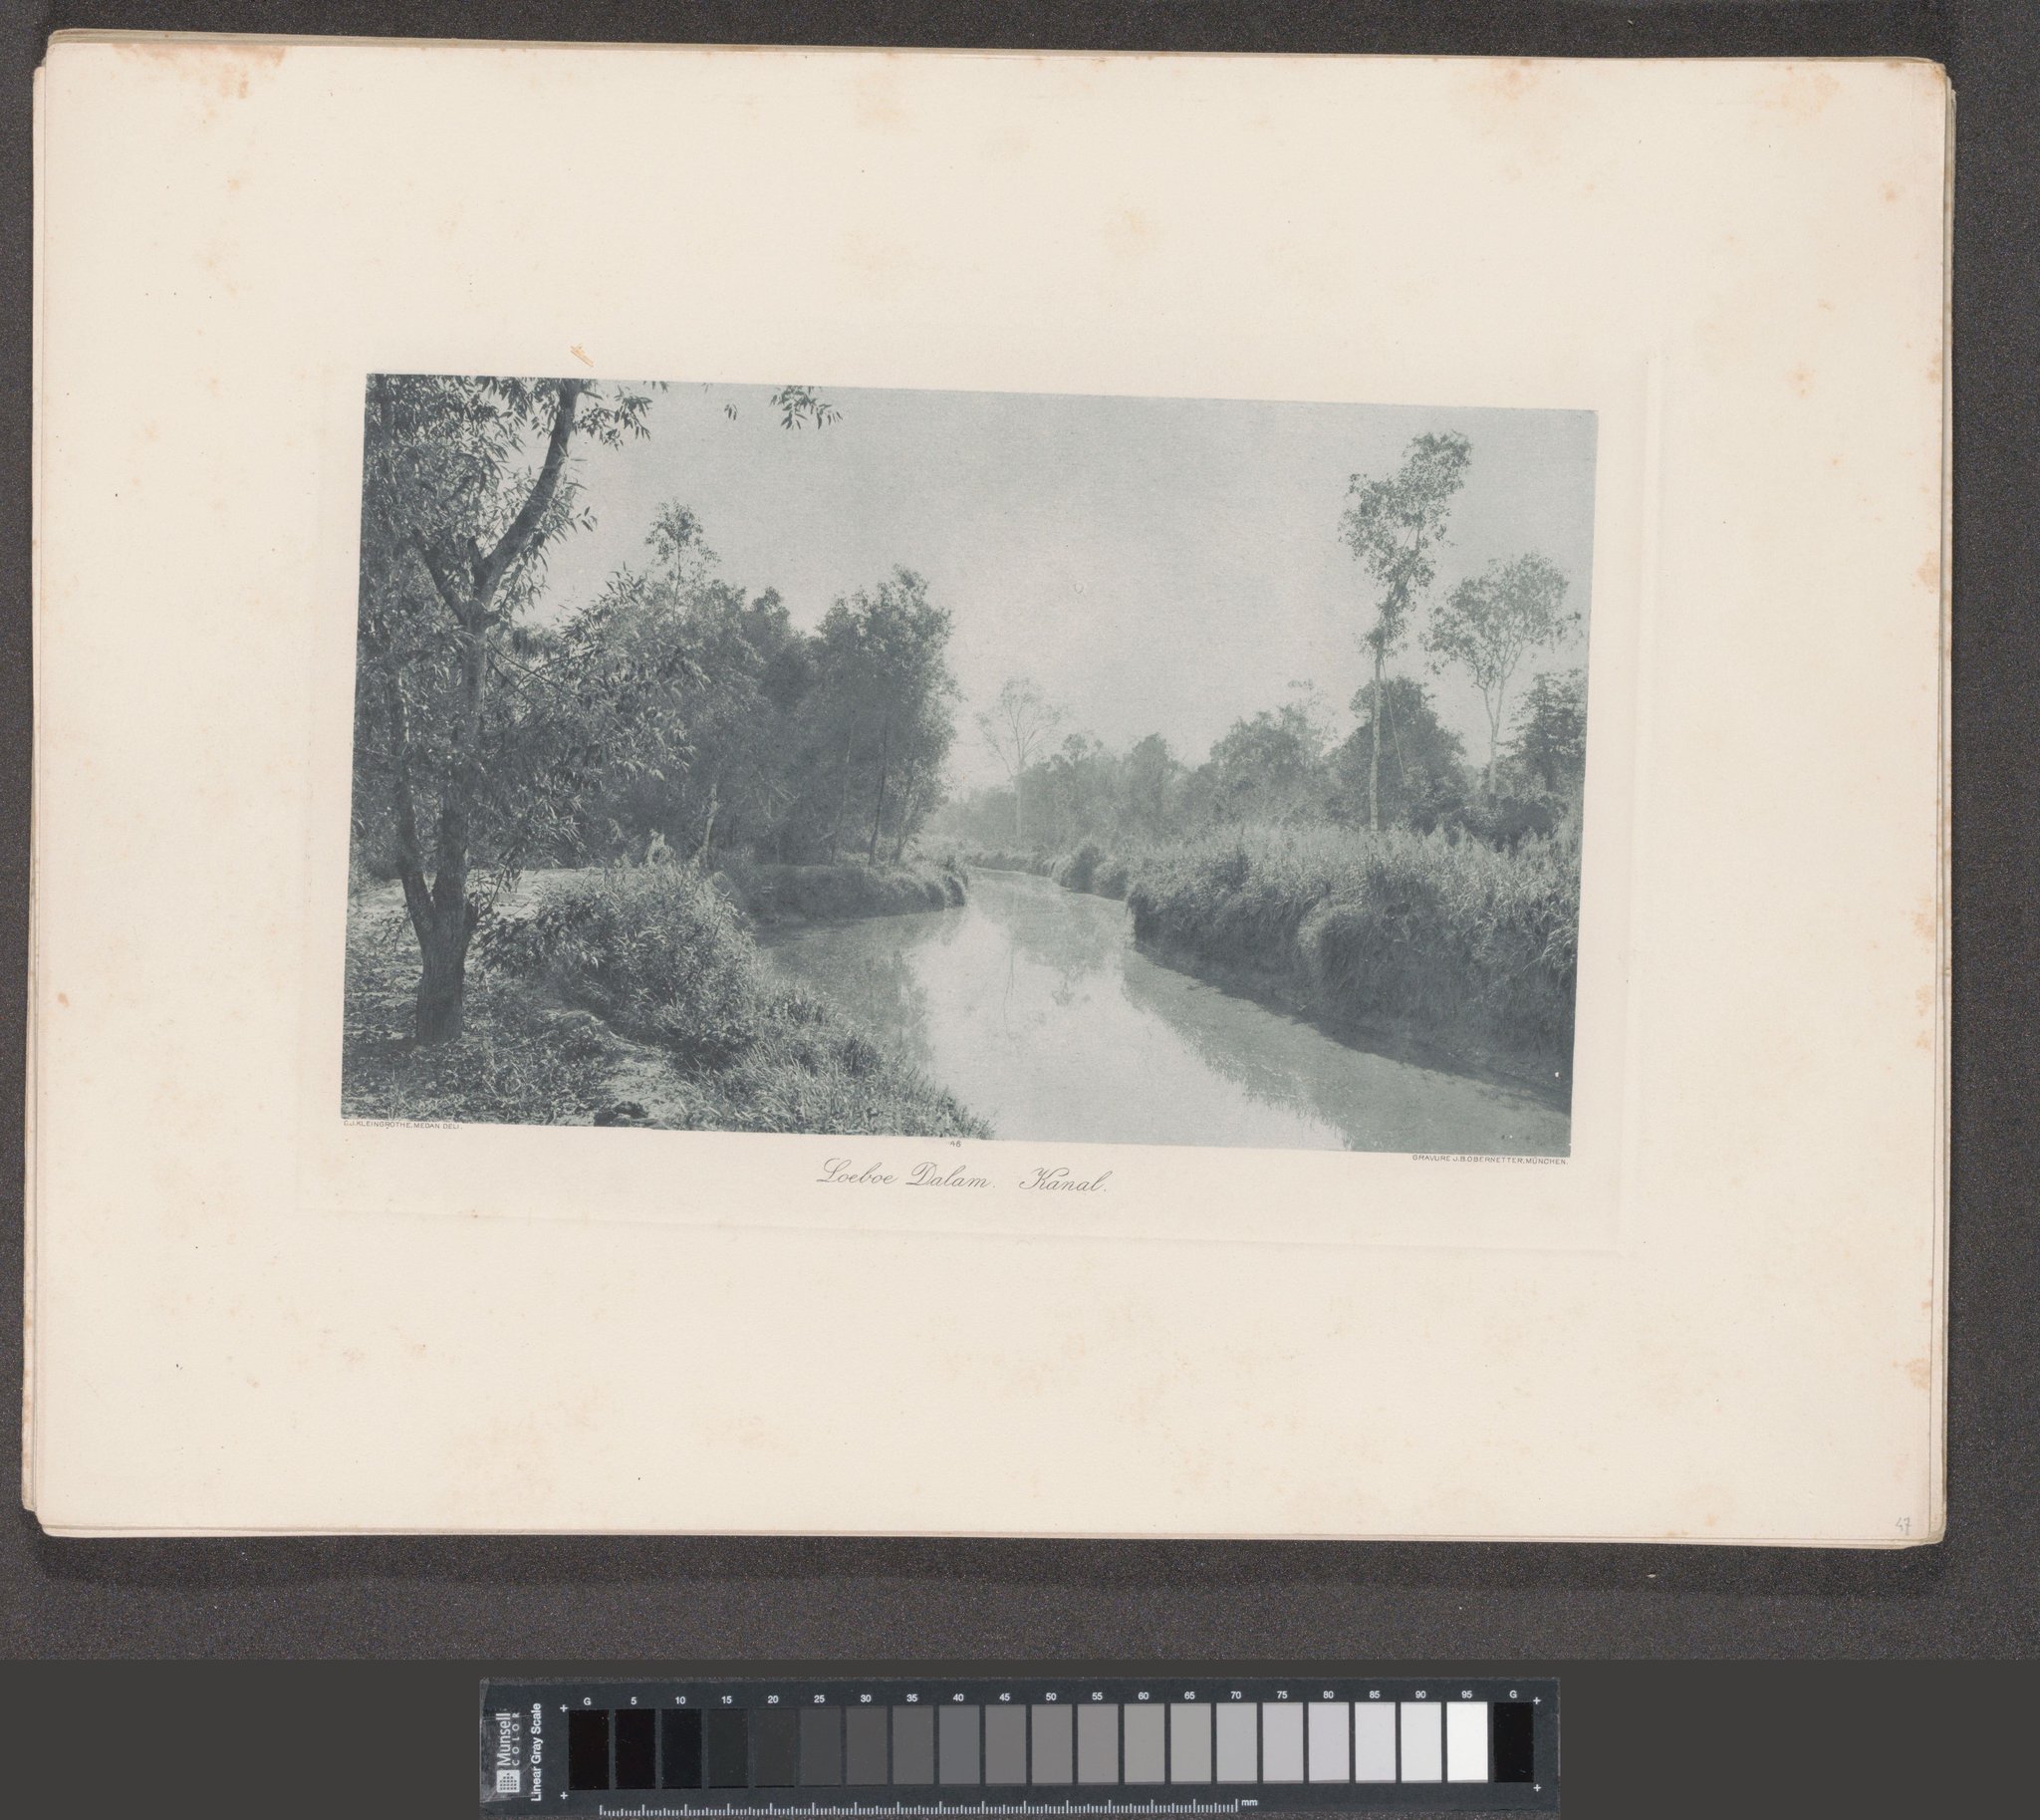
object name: photomechanical print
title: Afwateringskanaal bij Loeboe Dalam op Sumatra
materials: paper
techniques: photoaquatint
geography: sumatra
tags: small canal, ditch, sumatra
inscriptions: number: ‘46’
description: Onderdeel van Album met heliogravures van Sumatra's oostkust.